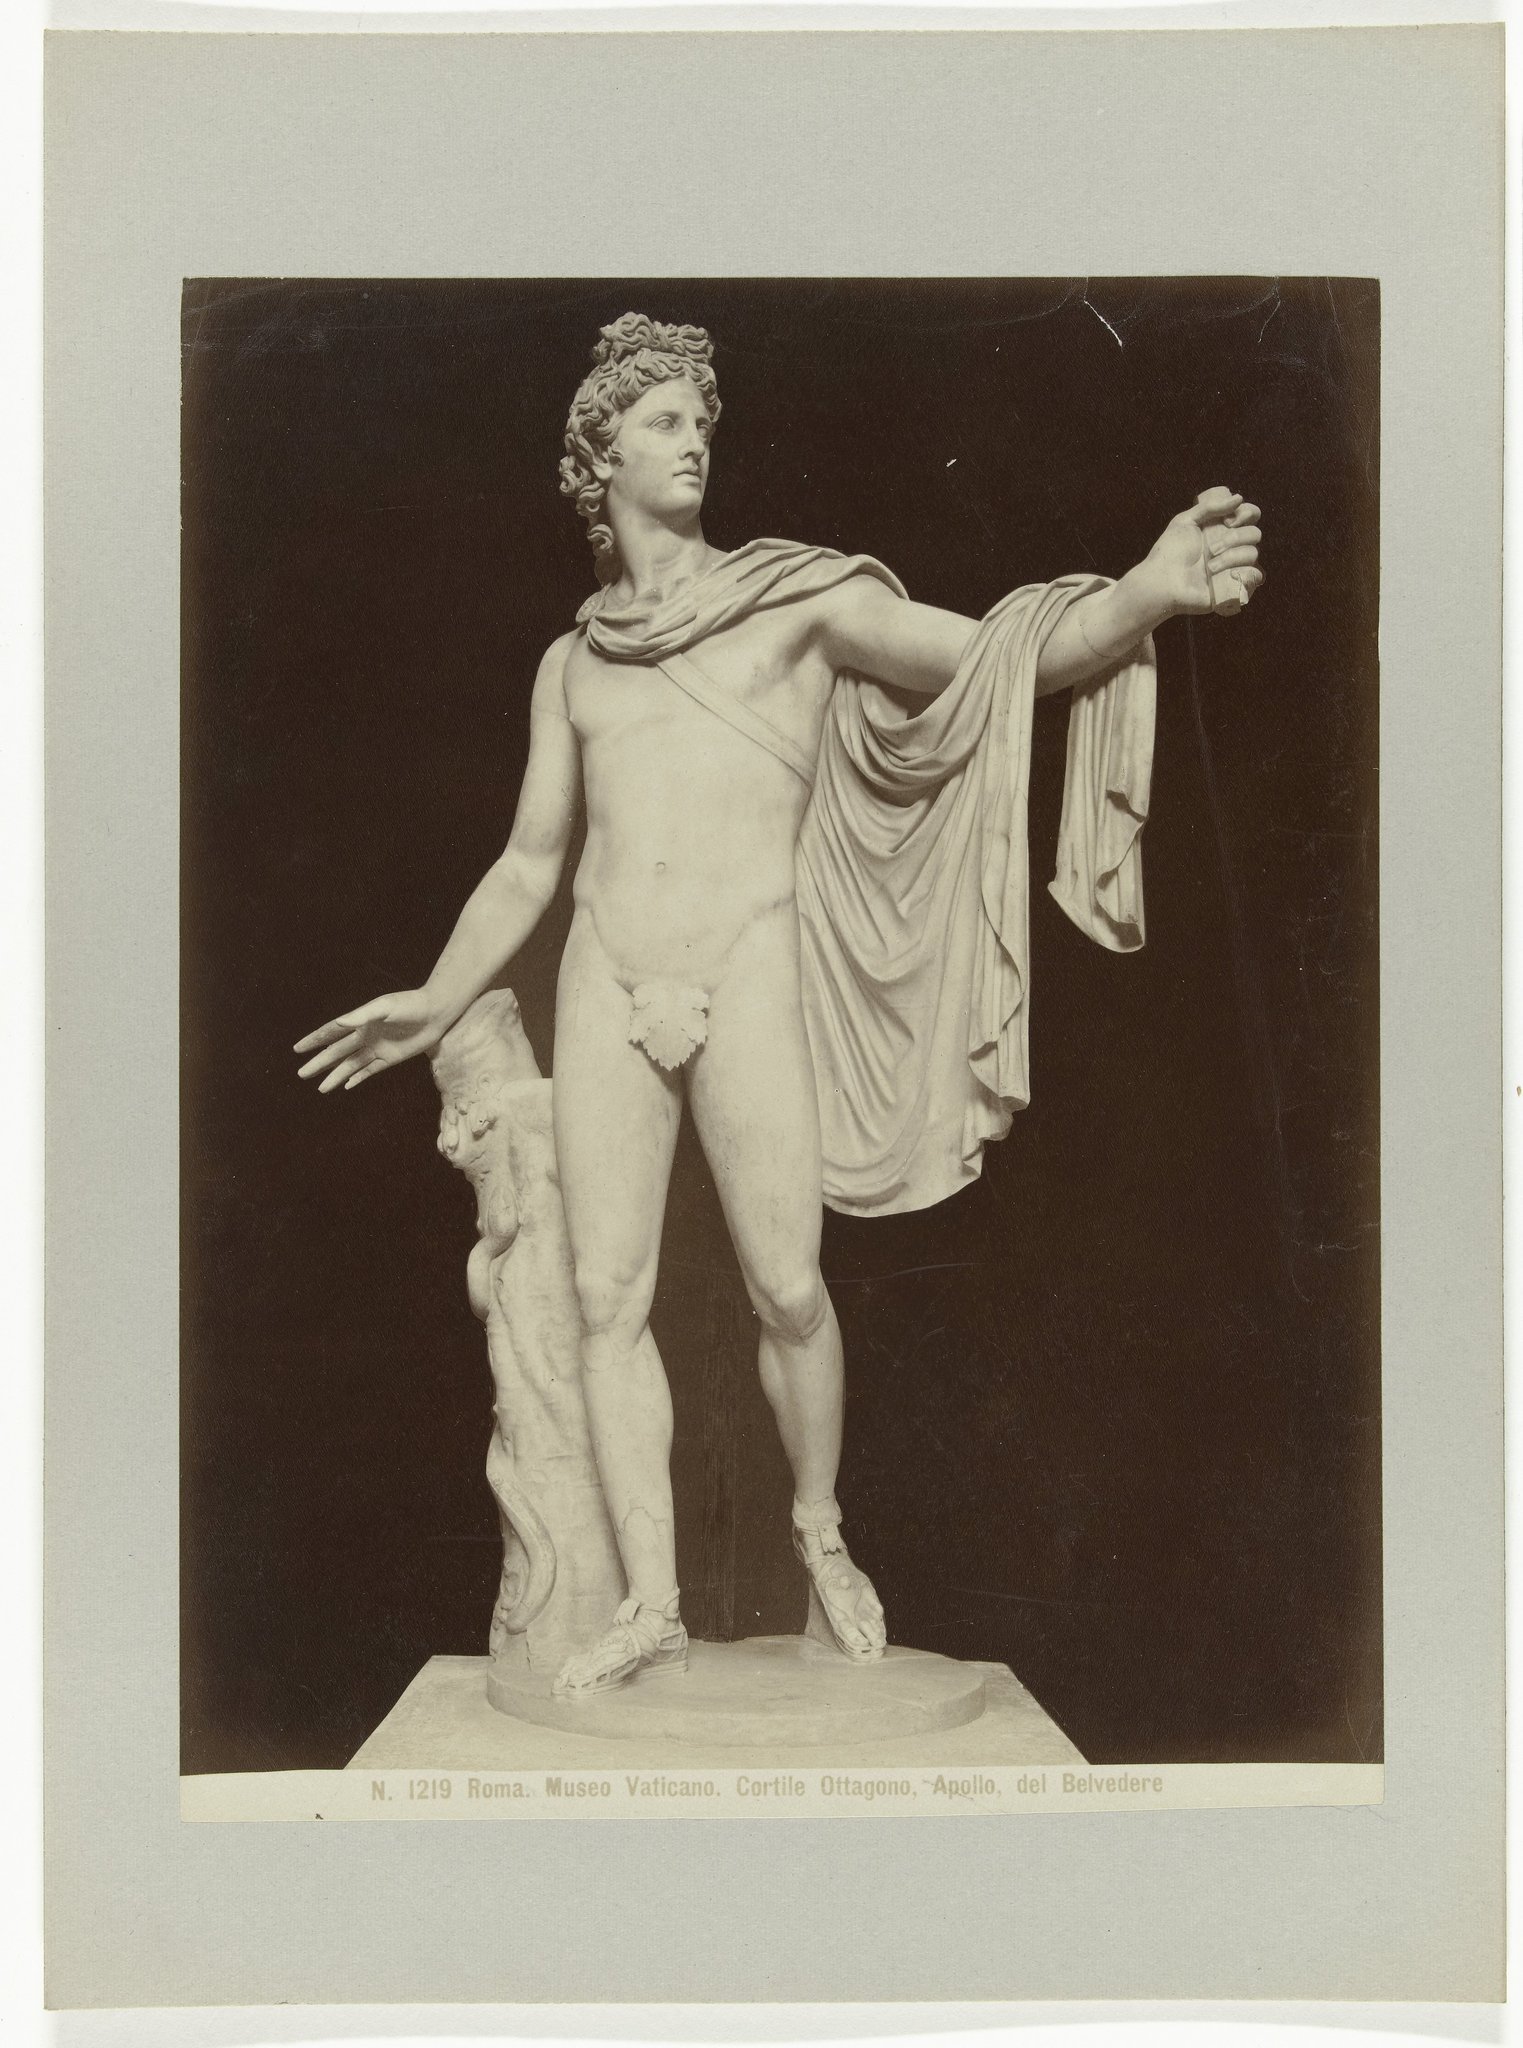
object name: photograph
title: Sculptuur van Apollo van de Belvedere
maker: Anonymous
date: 1880-1904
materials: cardboard, paper, photographic support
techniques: albumen print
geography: rome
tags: vaticaanse musea